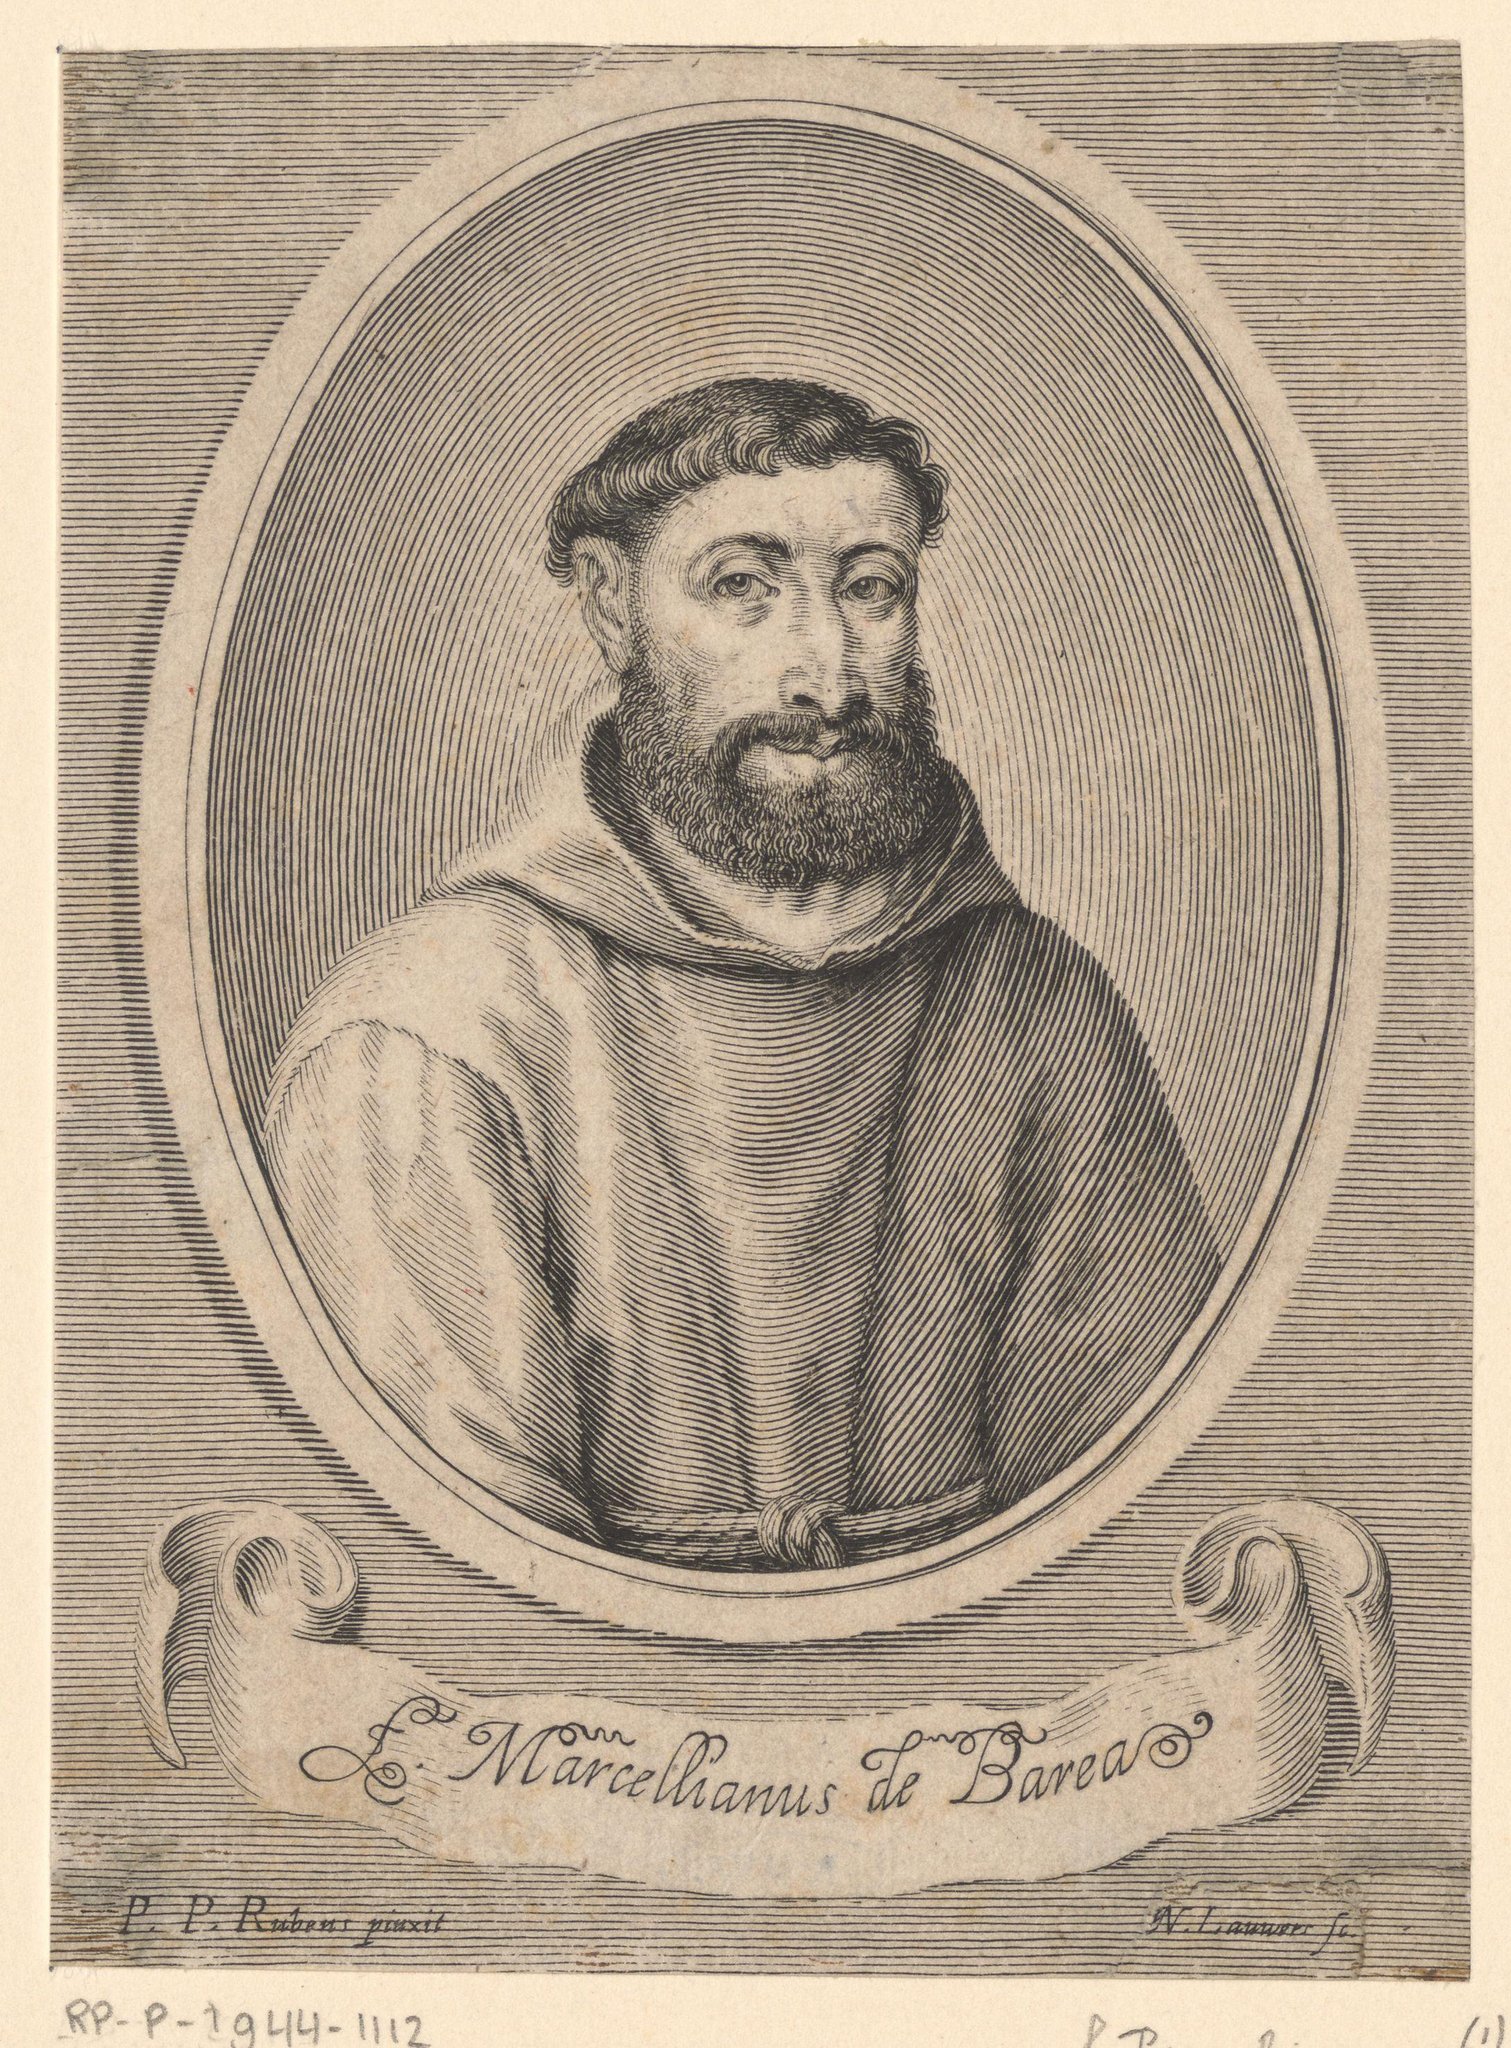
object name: print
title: Portret van Marcellianus de Barea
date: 1619-1652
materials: paper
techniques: engraving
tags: historical persons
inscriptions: collector's mark: Lugt 2228